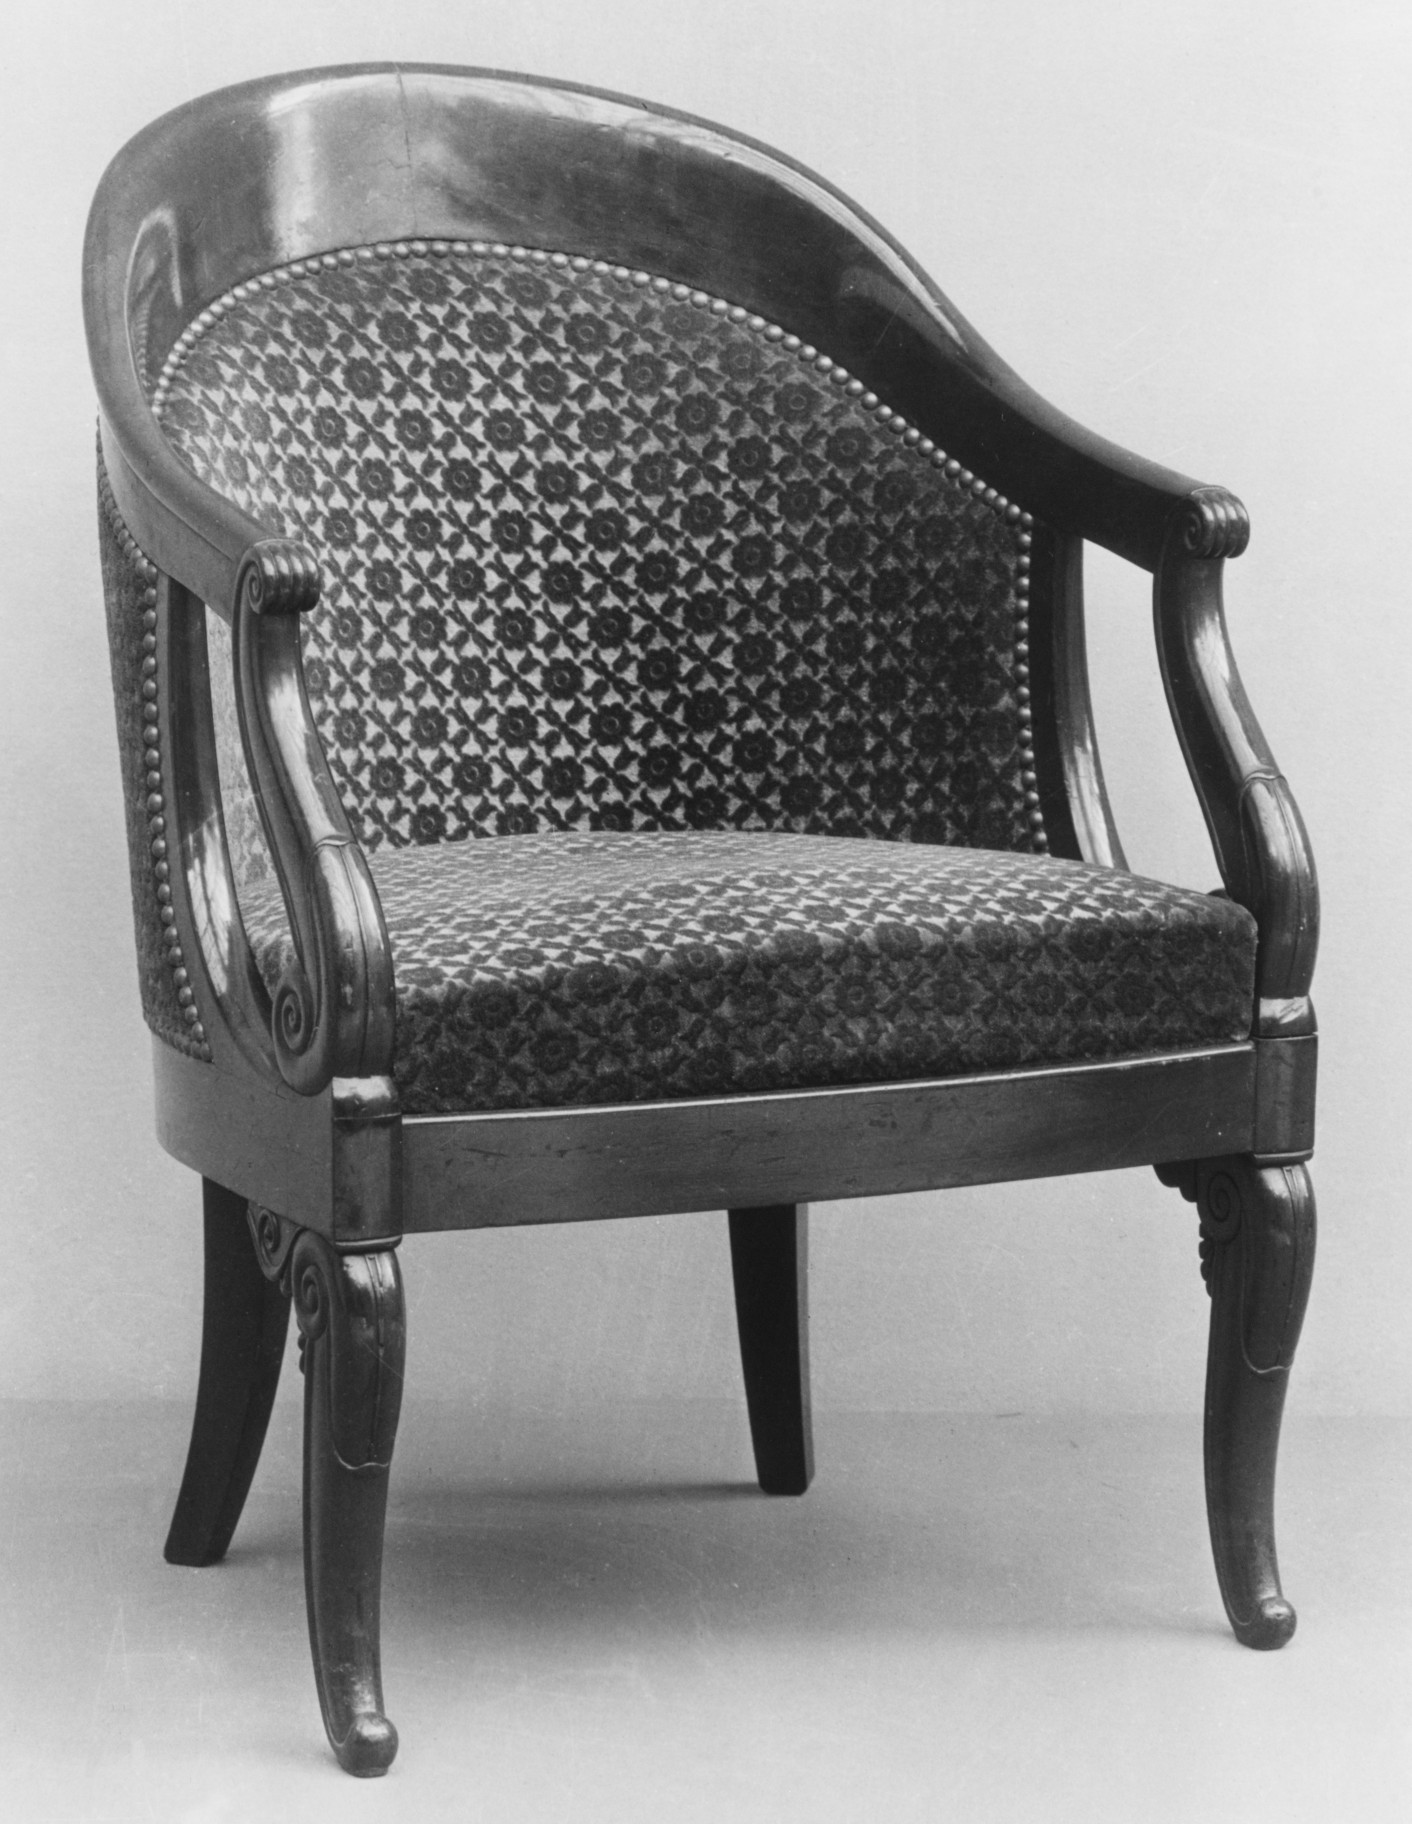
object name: armchair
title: Armchair (bergère en gondole)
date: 1820-1830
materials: velvet, wood